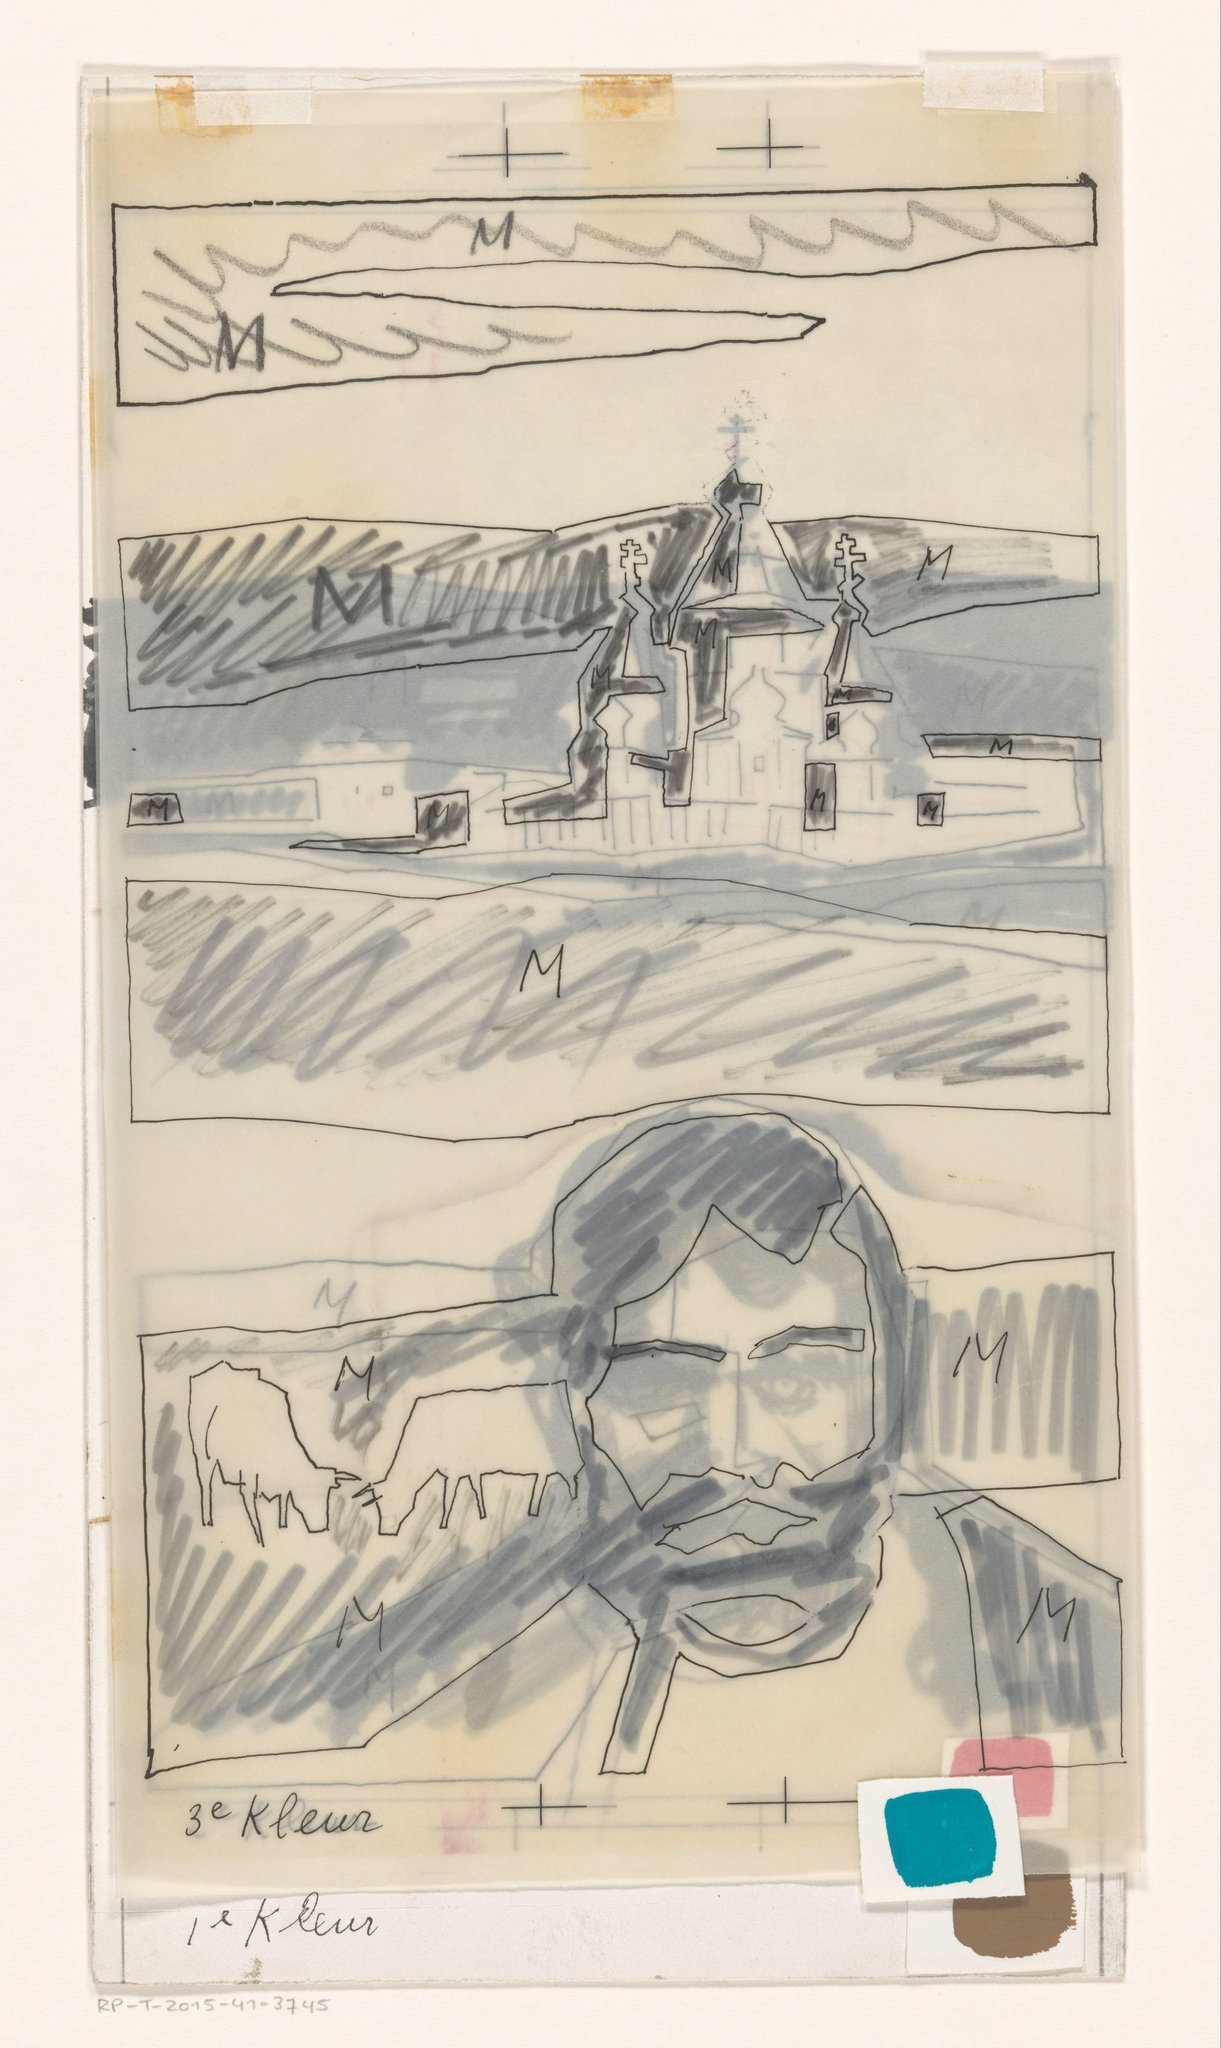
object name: study for binding design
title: Bandontwerp voor: N.S. Ljeskow, De onsterfelijke, 1965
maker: karel thole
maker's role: painter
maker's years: 1914-2000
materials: cardboard, ink, pencil, paper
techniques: brush, pen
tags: cow, church (exterior), beard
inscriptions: collector's mark: Lugt 2228a, : ‘3e kleur/ 2e kleur/ 1e kleur’, annotation: ‘DE ONSTERFELIJKE’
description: Landschap met een kerk. In de voorgrond grazende koeien en het hoofd van een man met een baard.